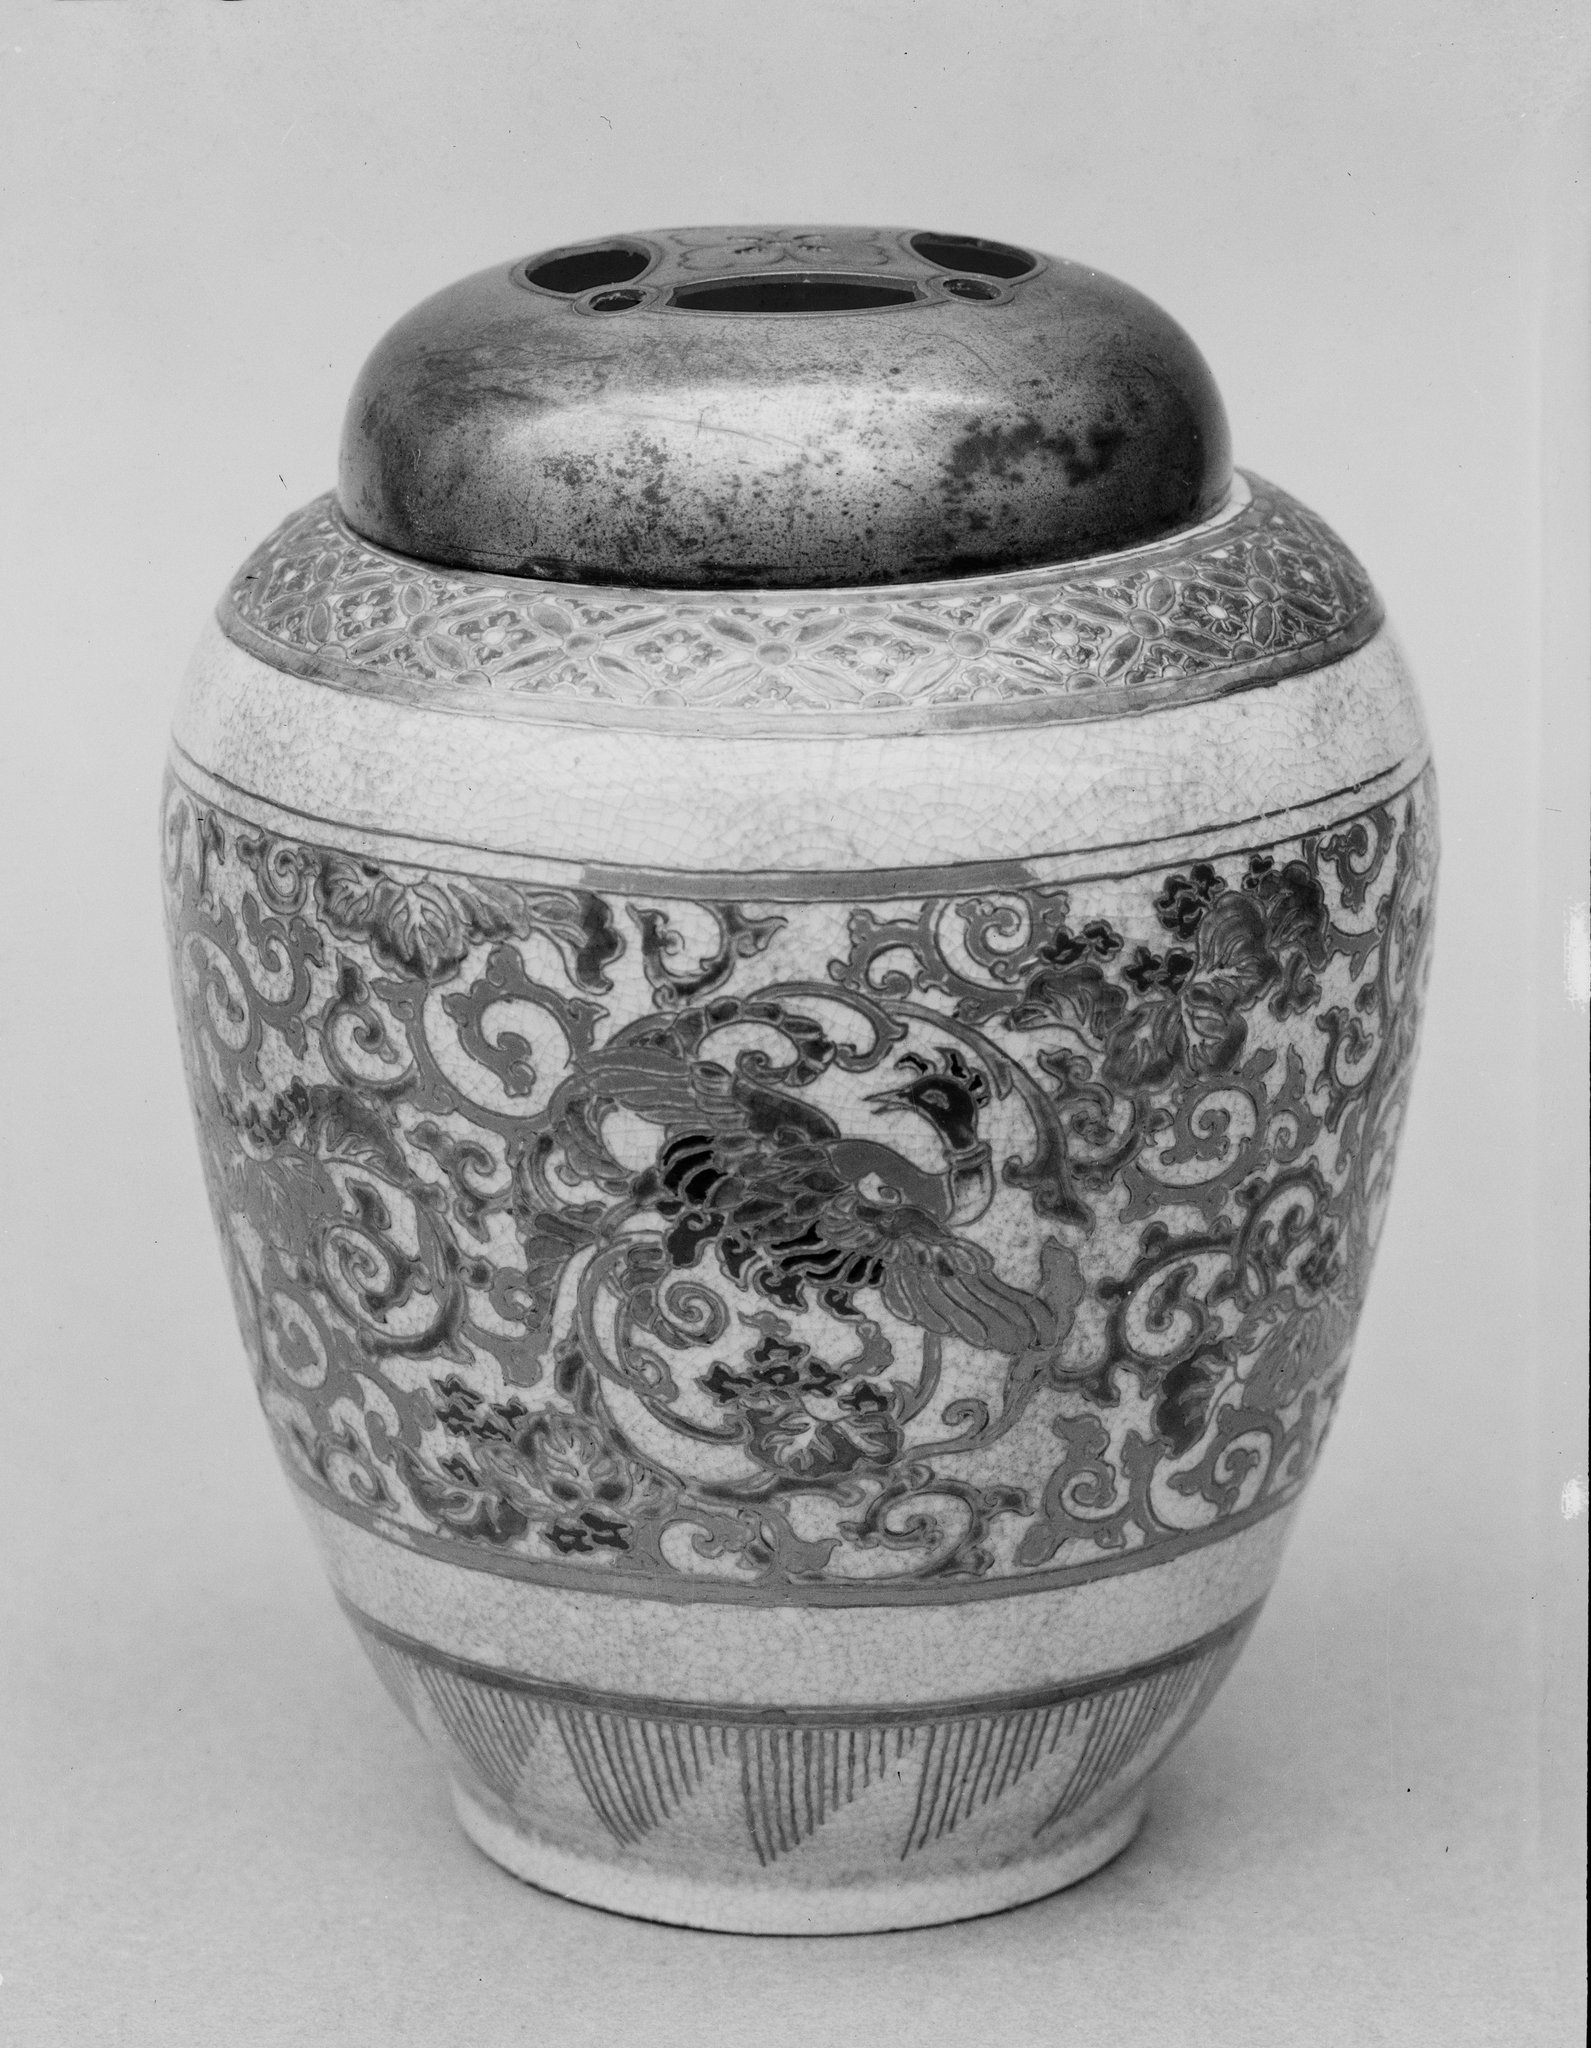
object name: jar with cover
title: Miniature Jar with Cover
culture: japanese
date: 1767-1800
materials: alloy, enamel, glaze, gold, porcelain, silver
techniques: cutting, enamel, incising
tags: birds